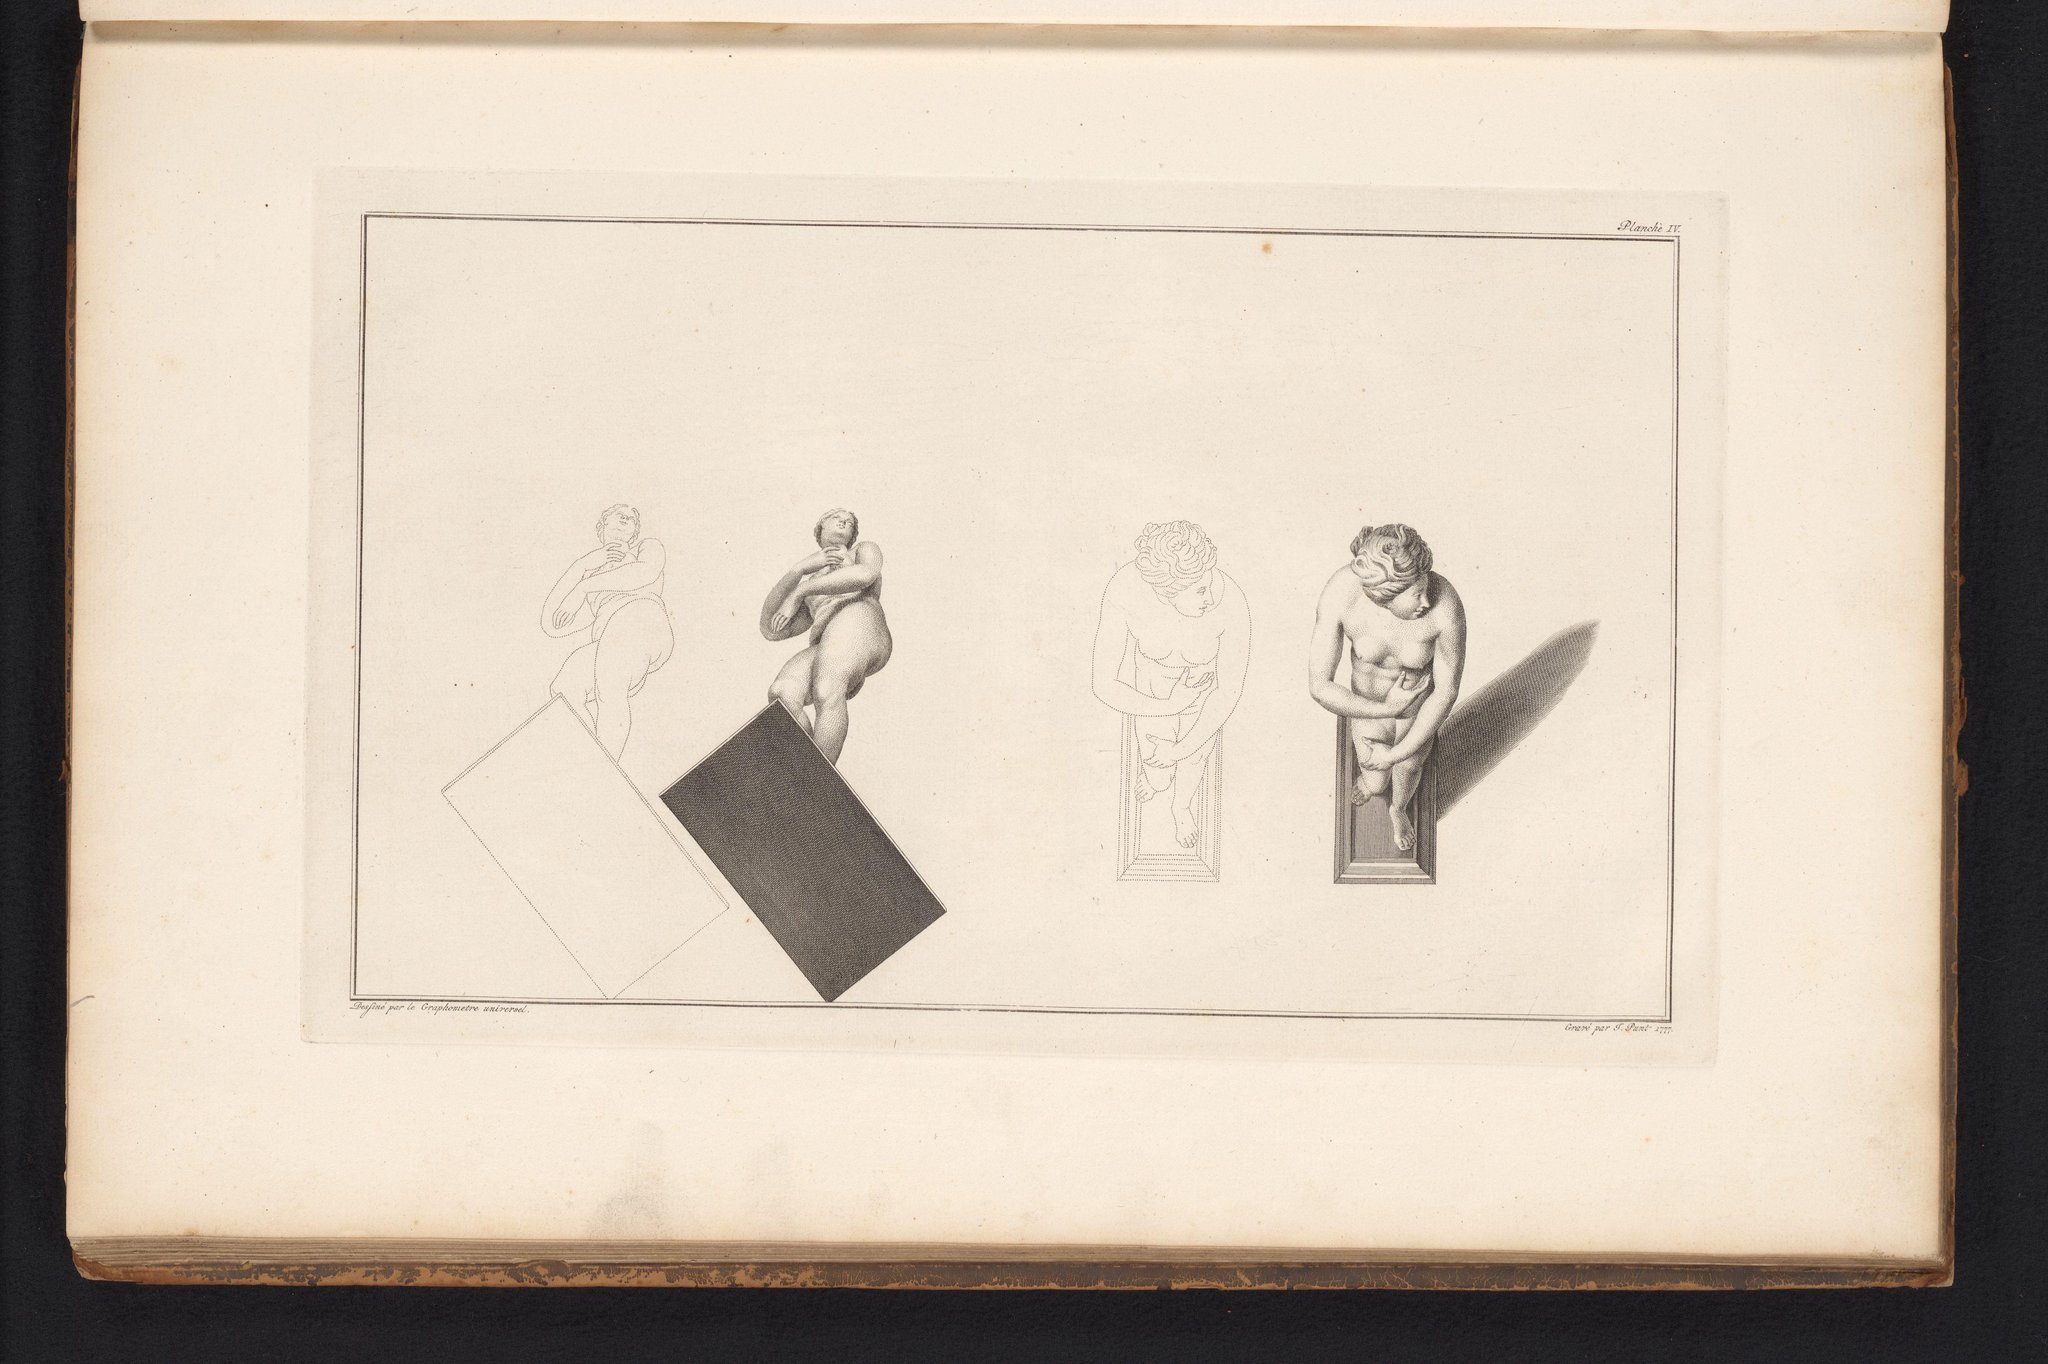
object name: album leaf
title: Beschryving van een' algemeenen graphometer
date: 1777-1778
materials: paper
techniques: engraving, etching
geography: amsterdam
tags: piece of sculpture, reproduction of a piece of sculpture, (story of) venus (aphrodite)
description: Het standbeeld van de Venus de' Medici, een antieke sculptuur van de godin Venus. Ze is afgebeeld in twee posities, de één bedoeld als afbeelding voor een plafond en de andere voor een tapijt. Eerst alleen in omtrek getekend met behulp van een grafometer. Rechtsboven gemerkt: Planche IV. De prent maakt deel uit van het boek: A.G. Eckhardt, Beschryving van een algemeenen graphometer, 1778.